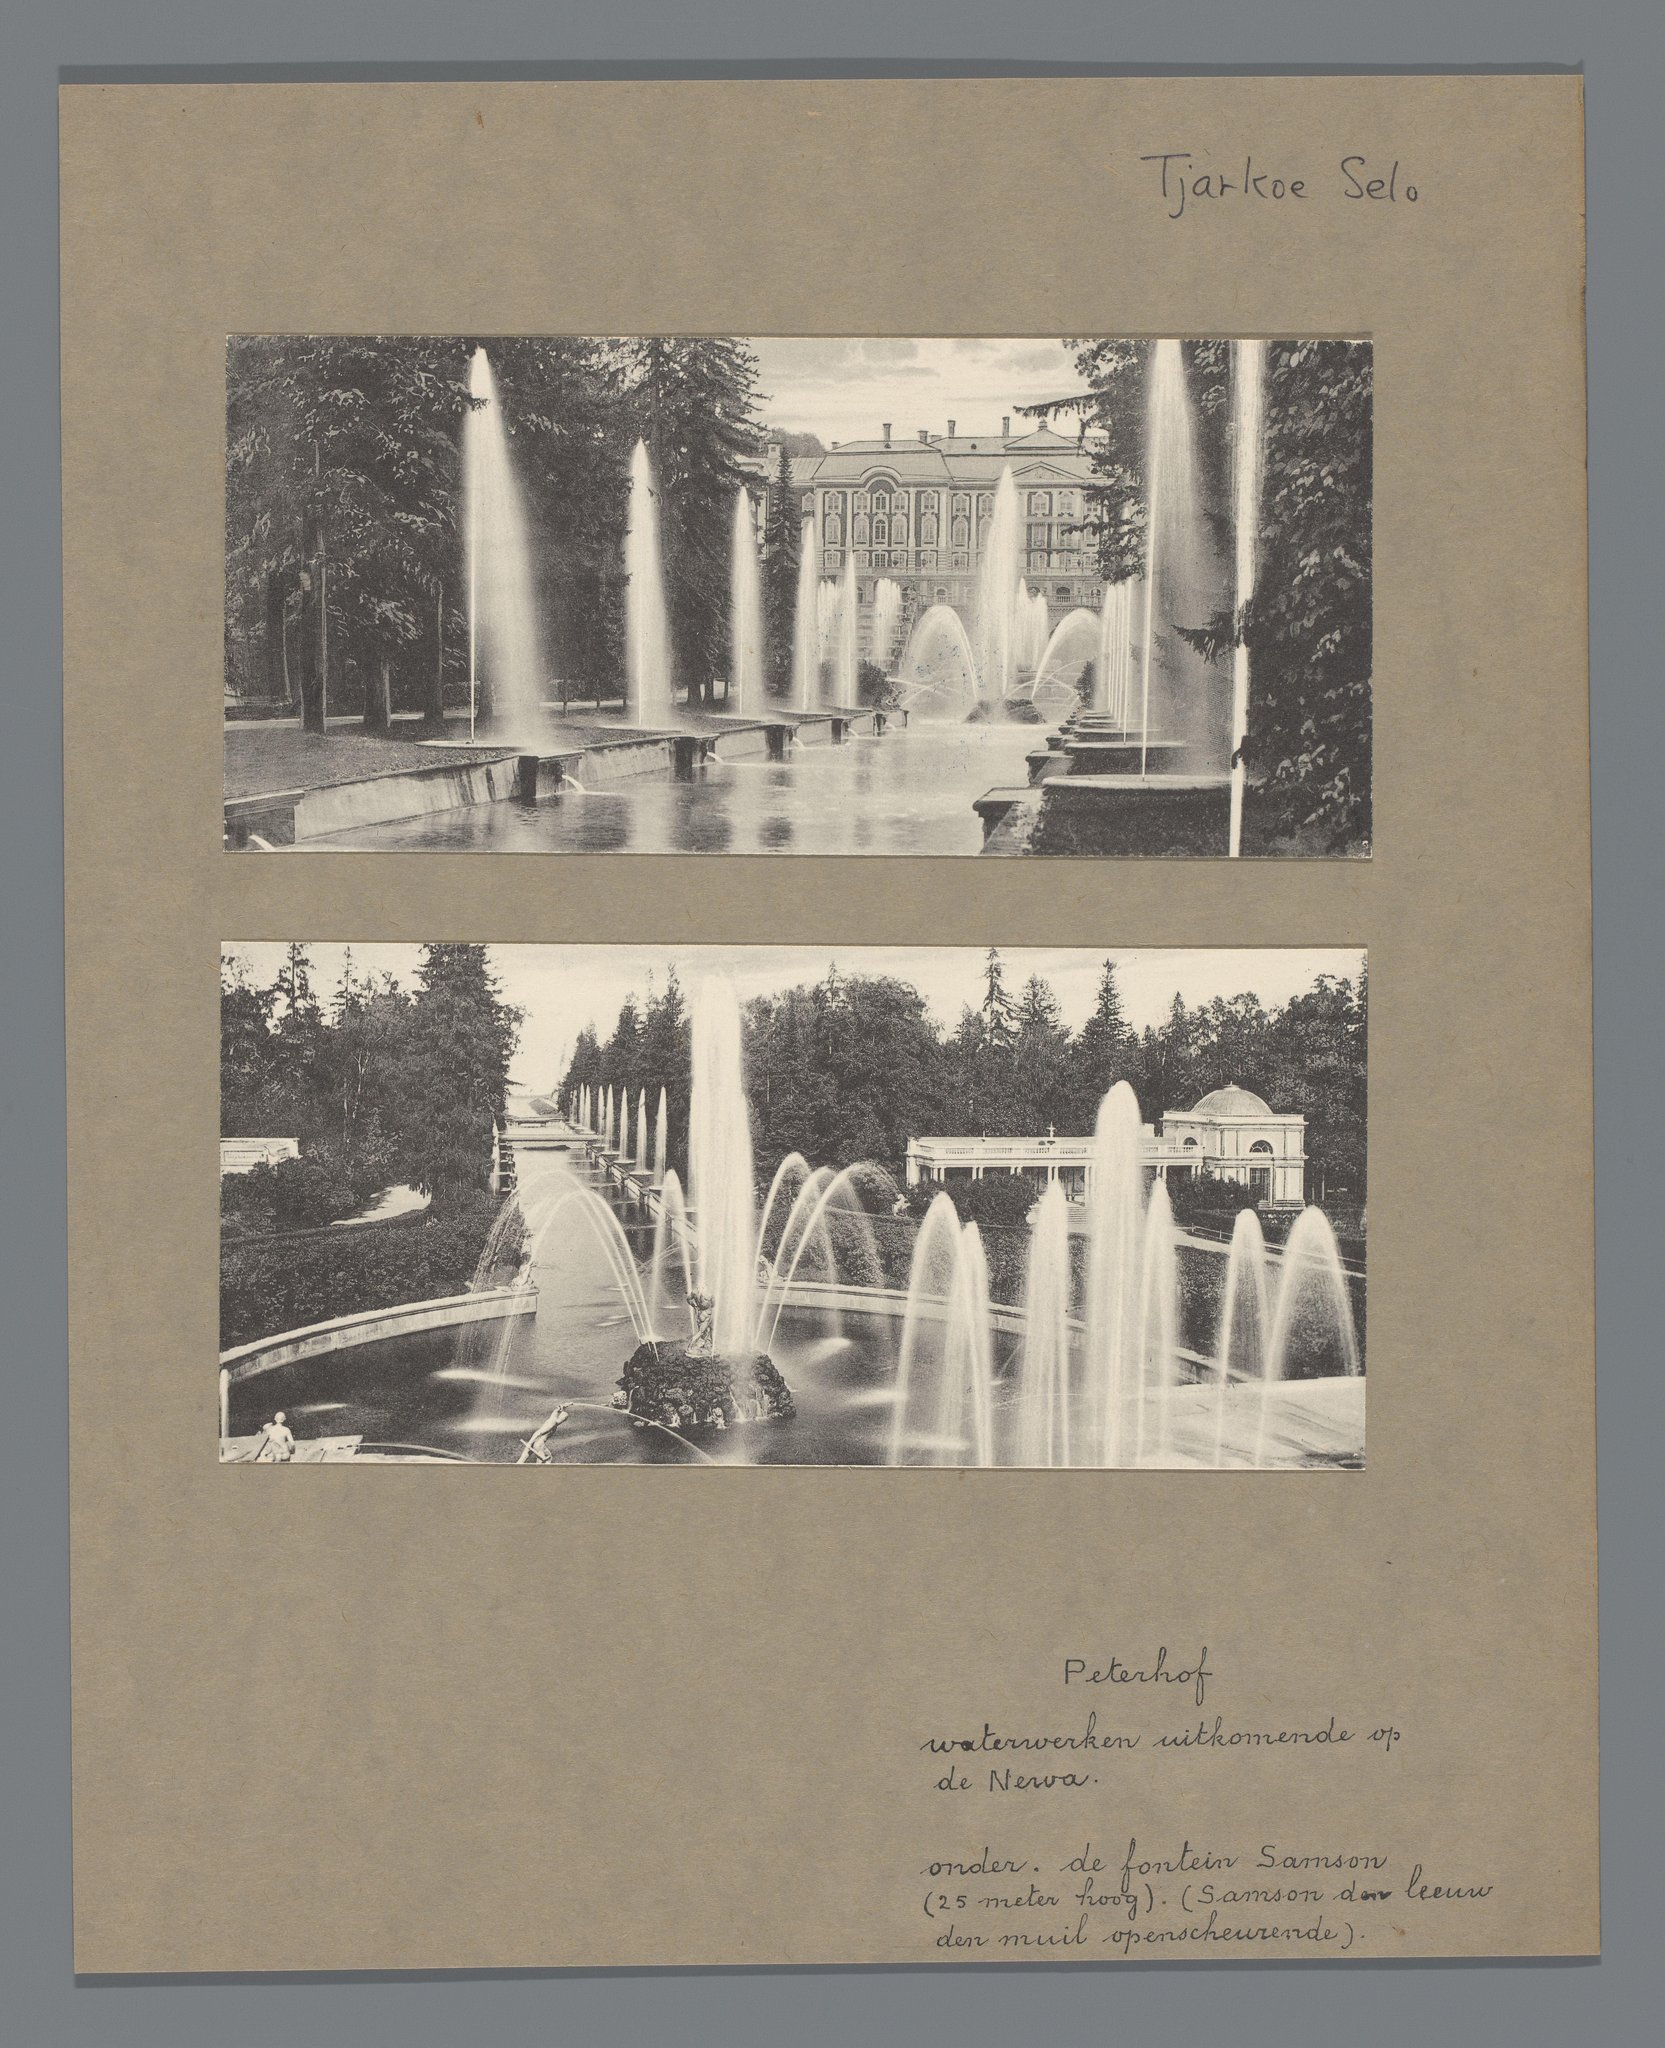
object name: photograph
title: Tjarkoe Selo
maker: Anonymous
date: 1860-1925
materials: photographic support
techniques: photograph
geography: russia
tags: russia